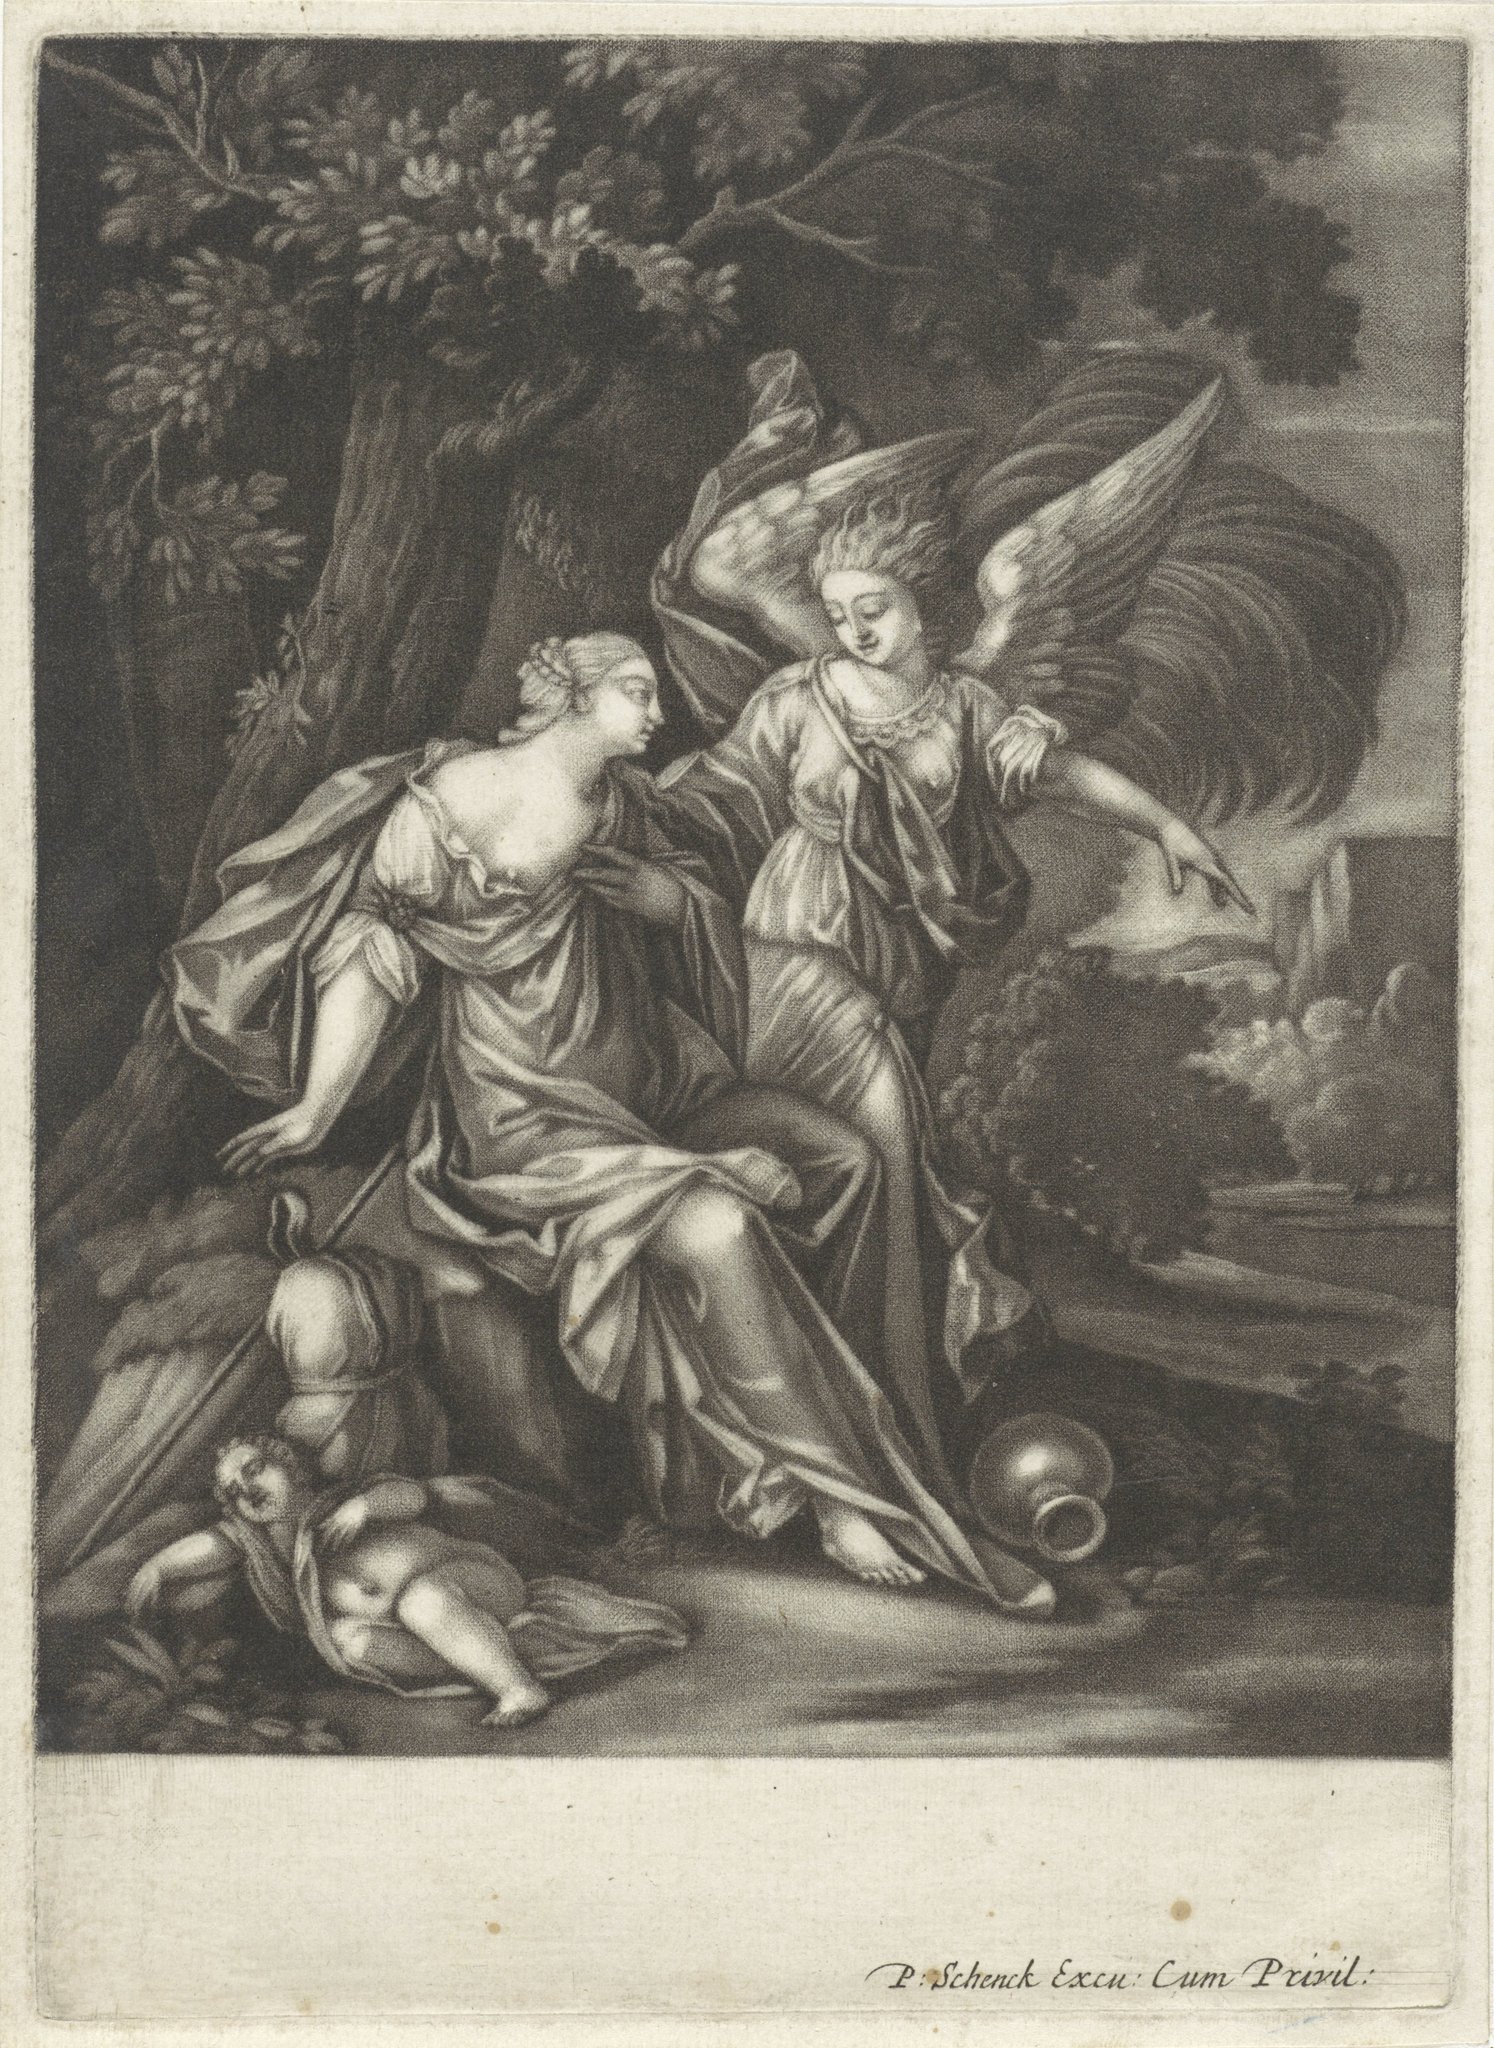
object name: print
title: Hagar en Ismaël in de wildernis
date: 1680-1713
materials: paper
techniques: engraving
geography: amsterdam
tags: an angel appears and reveals a well of water to hagar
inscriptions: collector's mark: Lugt 2228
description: Een engel wijst Hagar de weg naar een bron. Op de voorgrond haar zoon Ismaël.